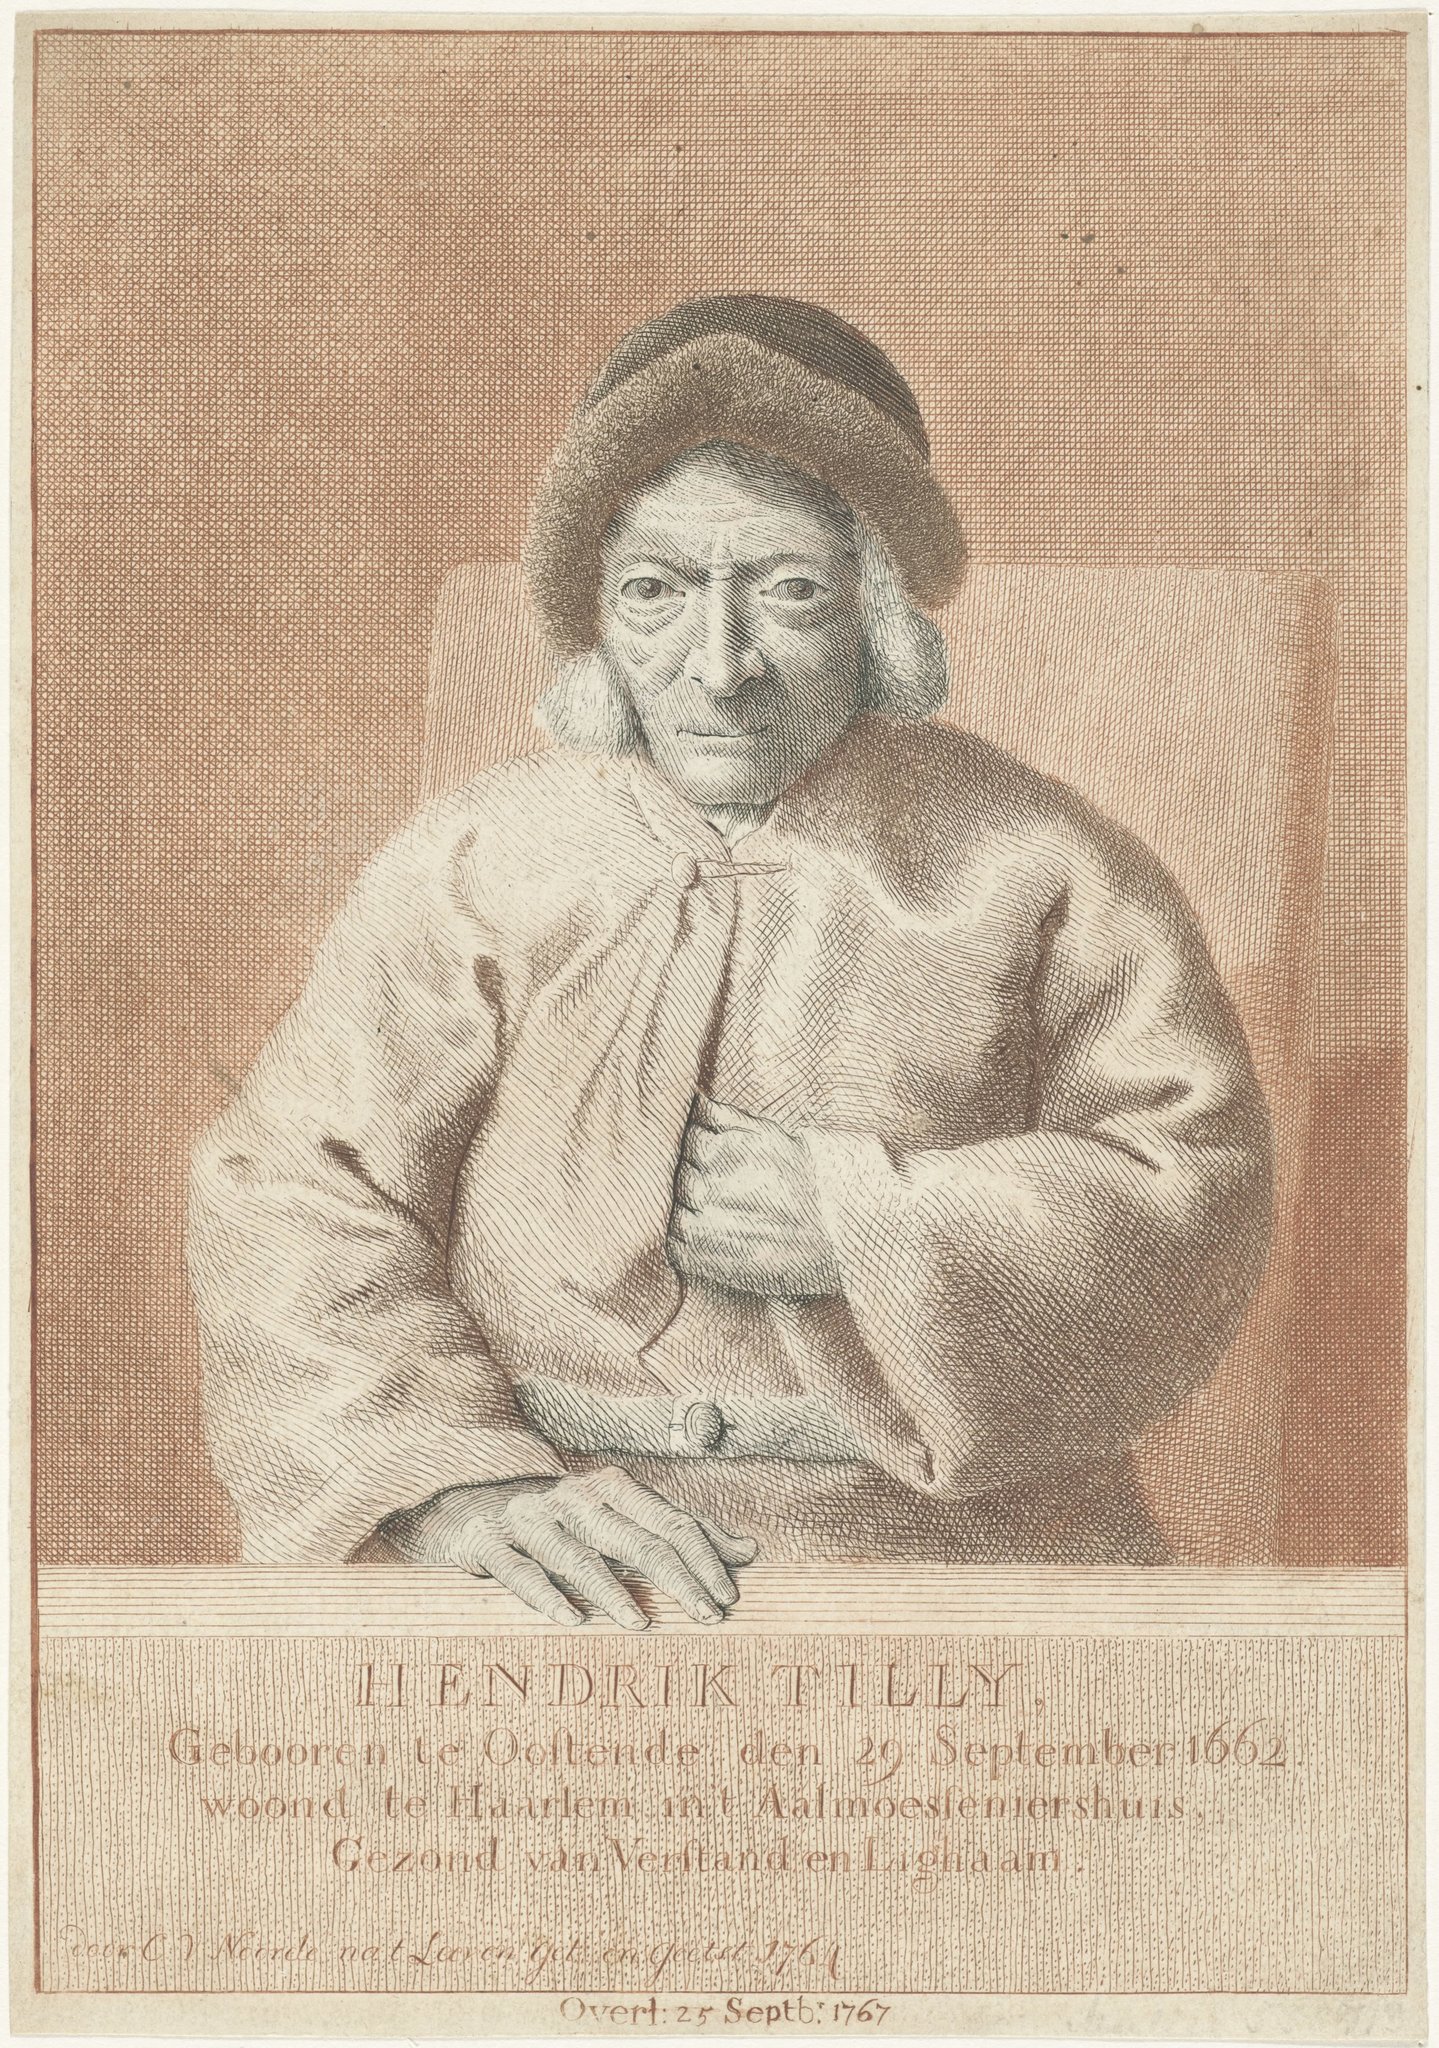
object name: print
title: Portret van Hendrik Tilly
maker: cornelis van noorde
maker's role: draughtsman, print maker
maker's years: 1731-1795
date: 1764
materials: paper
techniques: etching, lithography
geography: haarlem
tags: hendrik tilly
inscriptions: collector's mark: Lugt 2228, collector's mark: Lugt 2760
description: Portret van Hendrik Tilly op 102-jarige leeftijd. Hij woonde in het Aalmoezeniershuis van Haarlem en stierf op 105-jarige leeftijd.